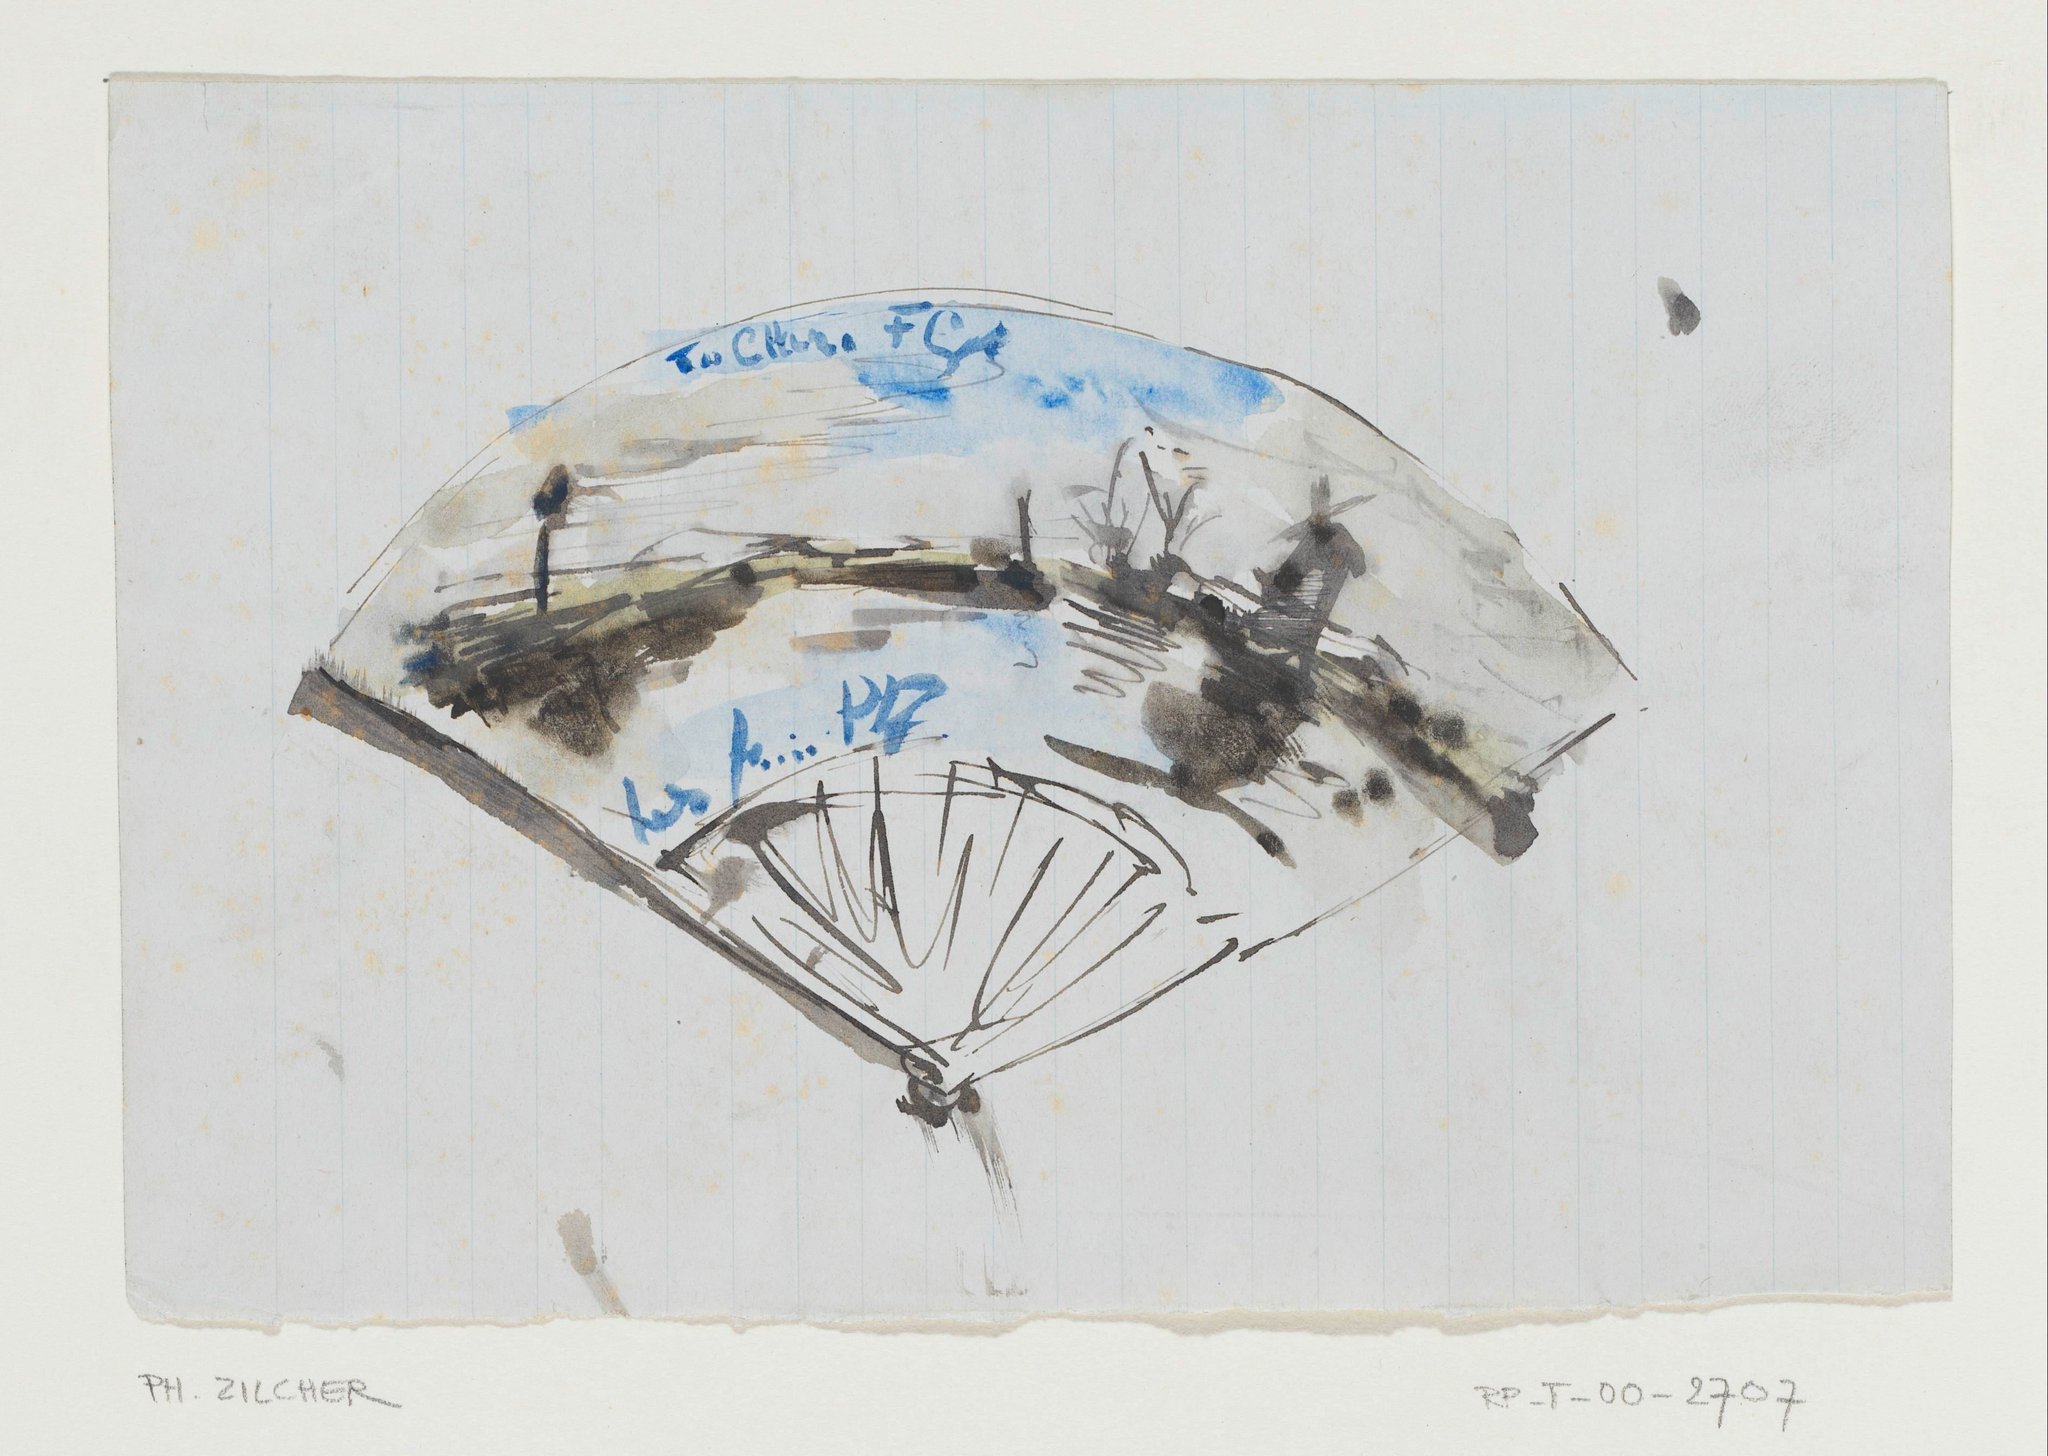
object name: watercolor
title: Waaier met landschap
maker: philip zilcken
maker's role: draughtsman, painter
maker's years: 1857-1930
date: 1867-1930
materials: ink, paper, watercolor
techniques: brush, pen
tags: fan